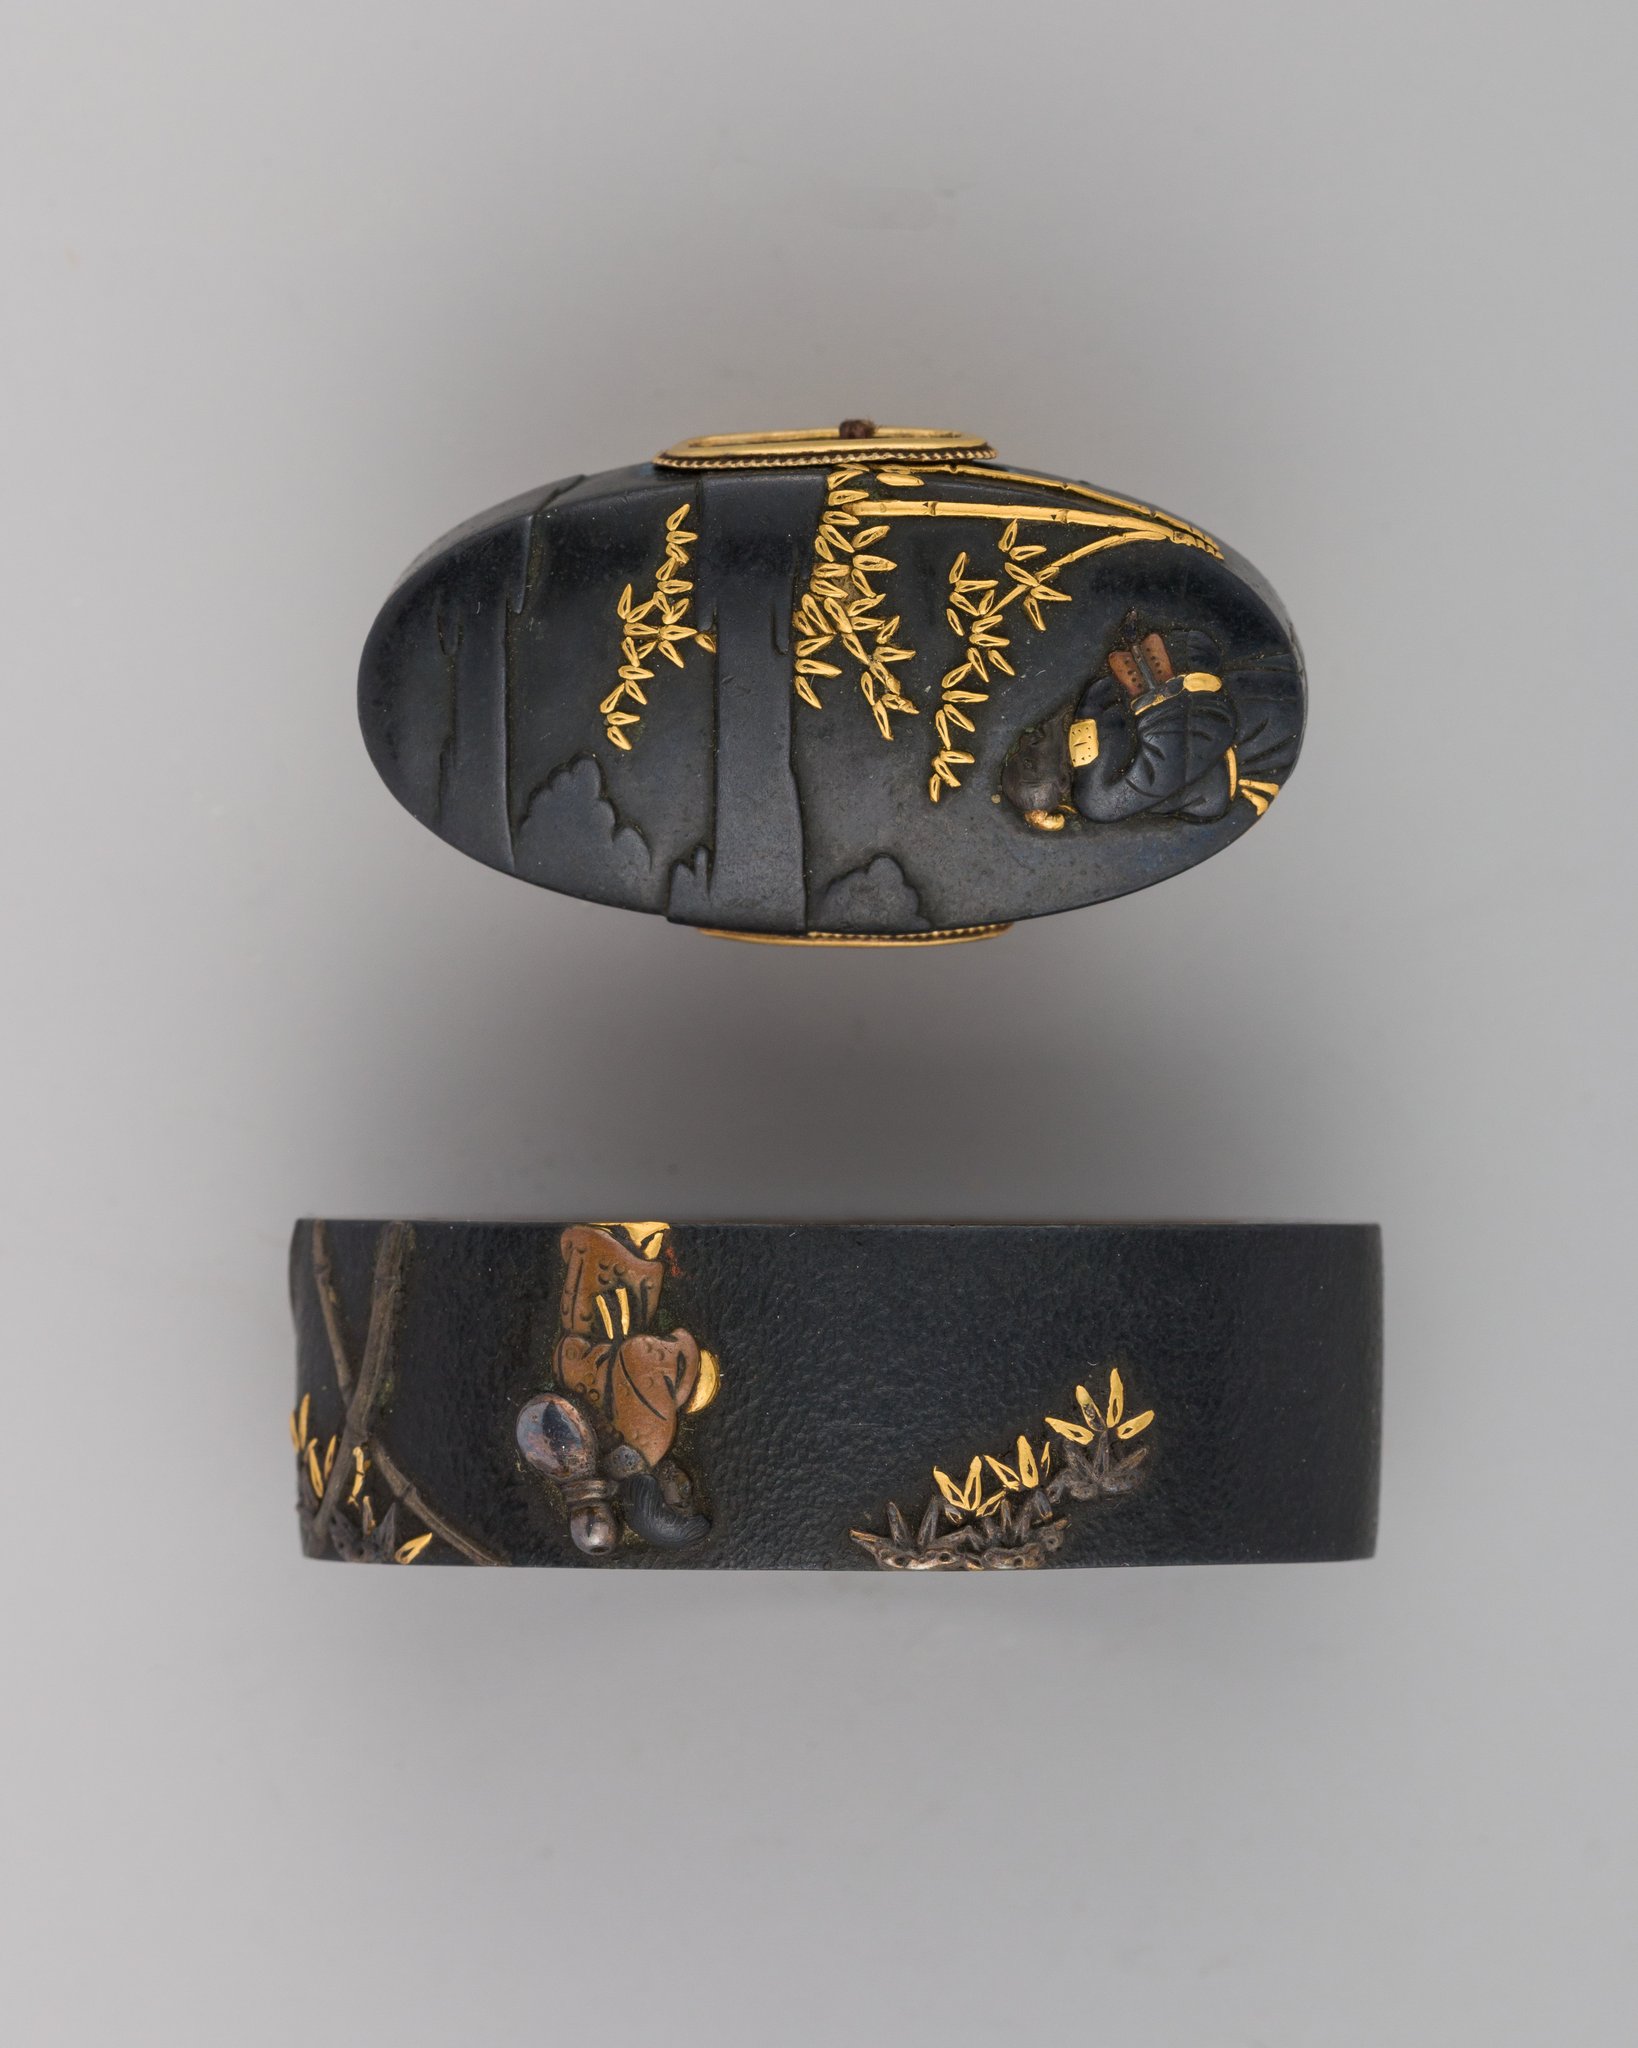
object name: sword hilt collar and pommel fuchigashira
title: Sword-Hilt Collar and Pommel (Fuchigashira)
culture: japanese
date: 1701-1800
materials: copper, gold alloy, silver alloy, gold, silver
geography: japan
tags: human figures,leaves